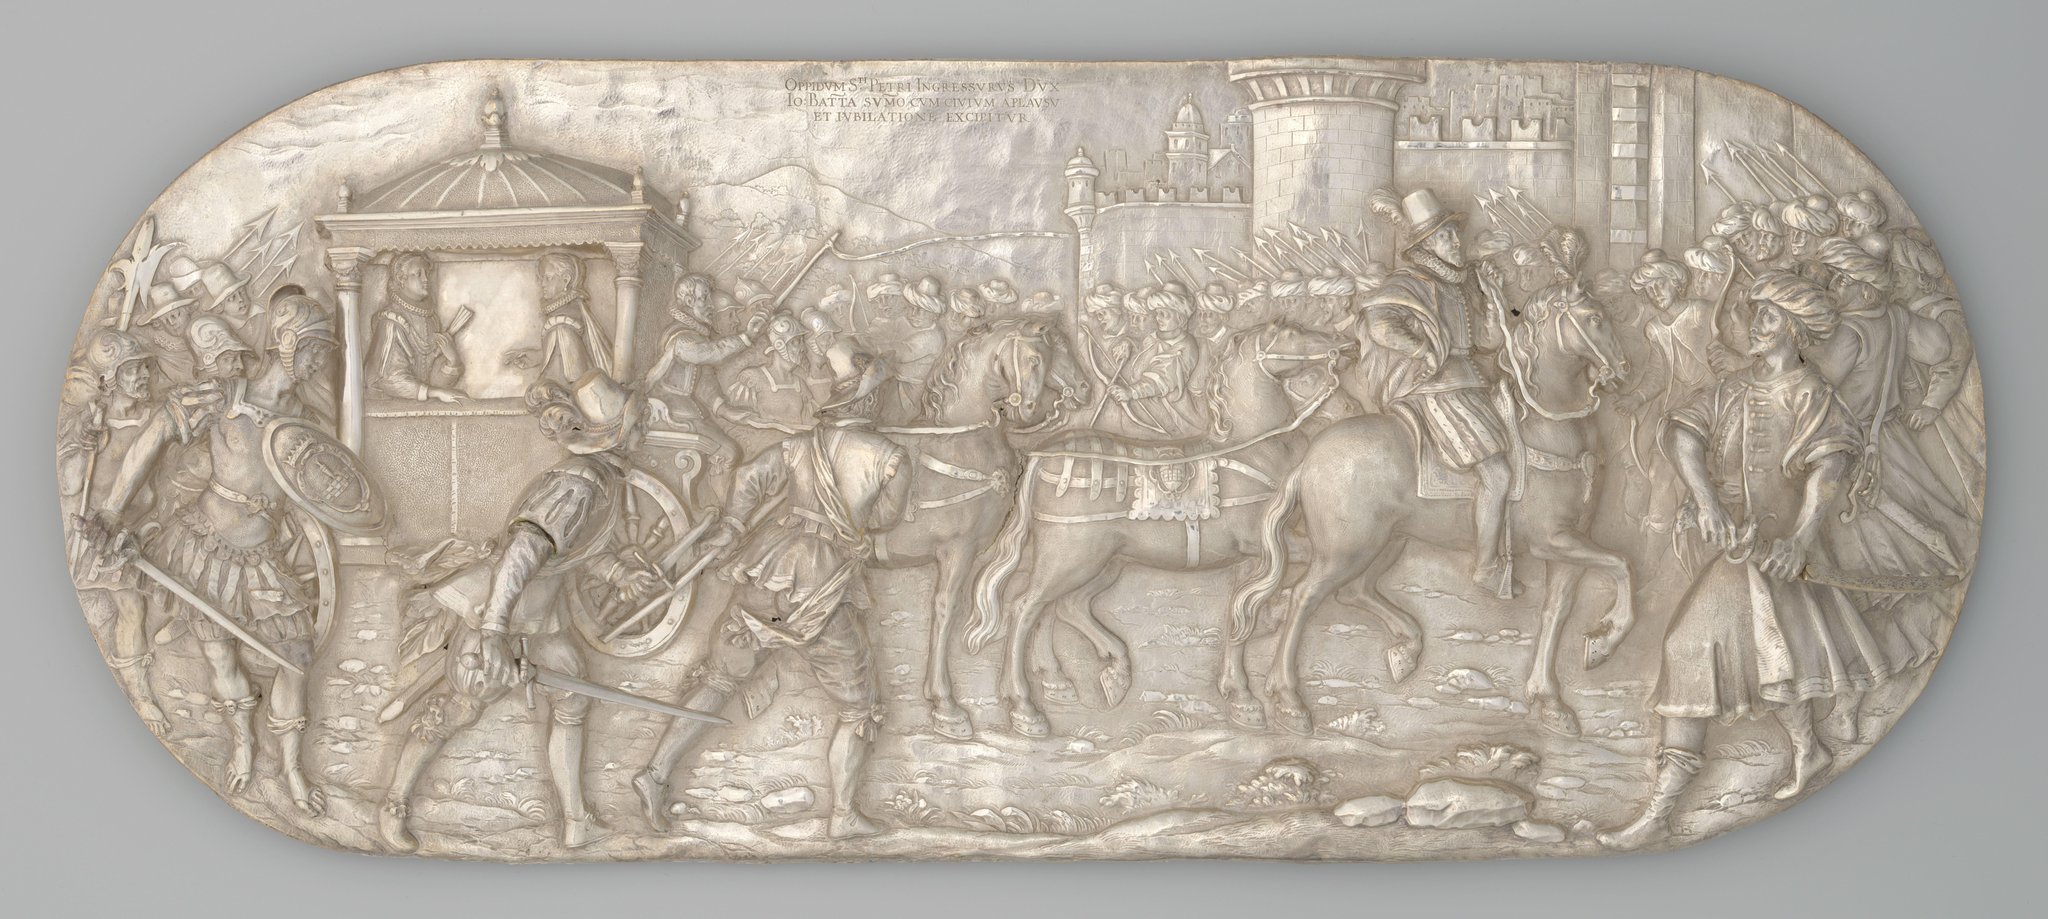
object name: plaque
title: Box with Episodes from the Life of the Spinola Family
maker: mattheus melijn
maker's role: silversmith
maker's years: 1588-1653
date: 1636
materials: silver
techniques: repoussé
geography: southern netherlands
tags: giovanni battista spinola, triumphal entry and public reception, pageant, 'entrée solennelle', 'joyeuse entrée', italy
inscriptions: signature: ‘Mateus Melin’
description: In the 17th century various silversmiths from the Netherlands were active in the Italian city of Genoa. They were celebrated for their skills in rendering stories in very high relief. These plaquettes are made by the most famous of these craftsmen, Mattheus Melijn of Antwerp. They feature episodes from the life of the Spinola family, and show how a city can be conquered: Maria Spinola procured a duchy through the power of love, her brother Ambrogio through military might. In the coach at the left are Maria and her cousin and husband Gianbattista Spinola. In 1616, they are jubilantly greeted by the people of their new duchy, San Pietro in Galatina, on Sicily. Various worlds came together in this duchy; at the right are Turks with turbans and scimitars and at the left Romans in full armour.